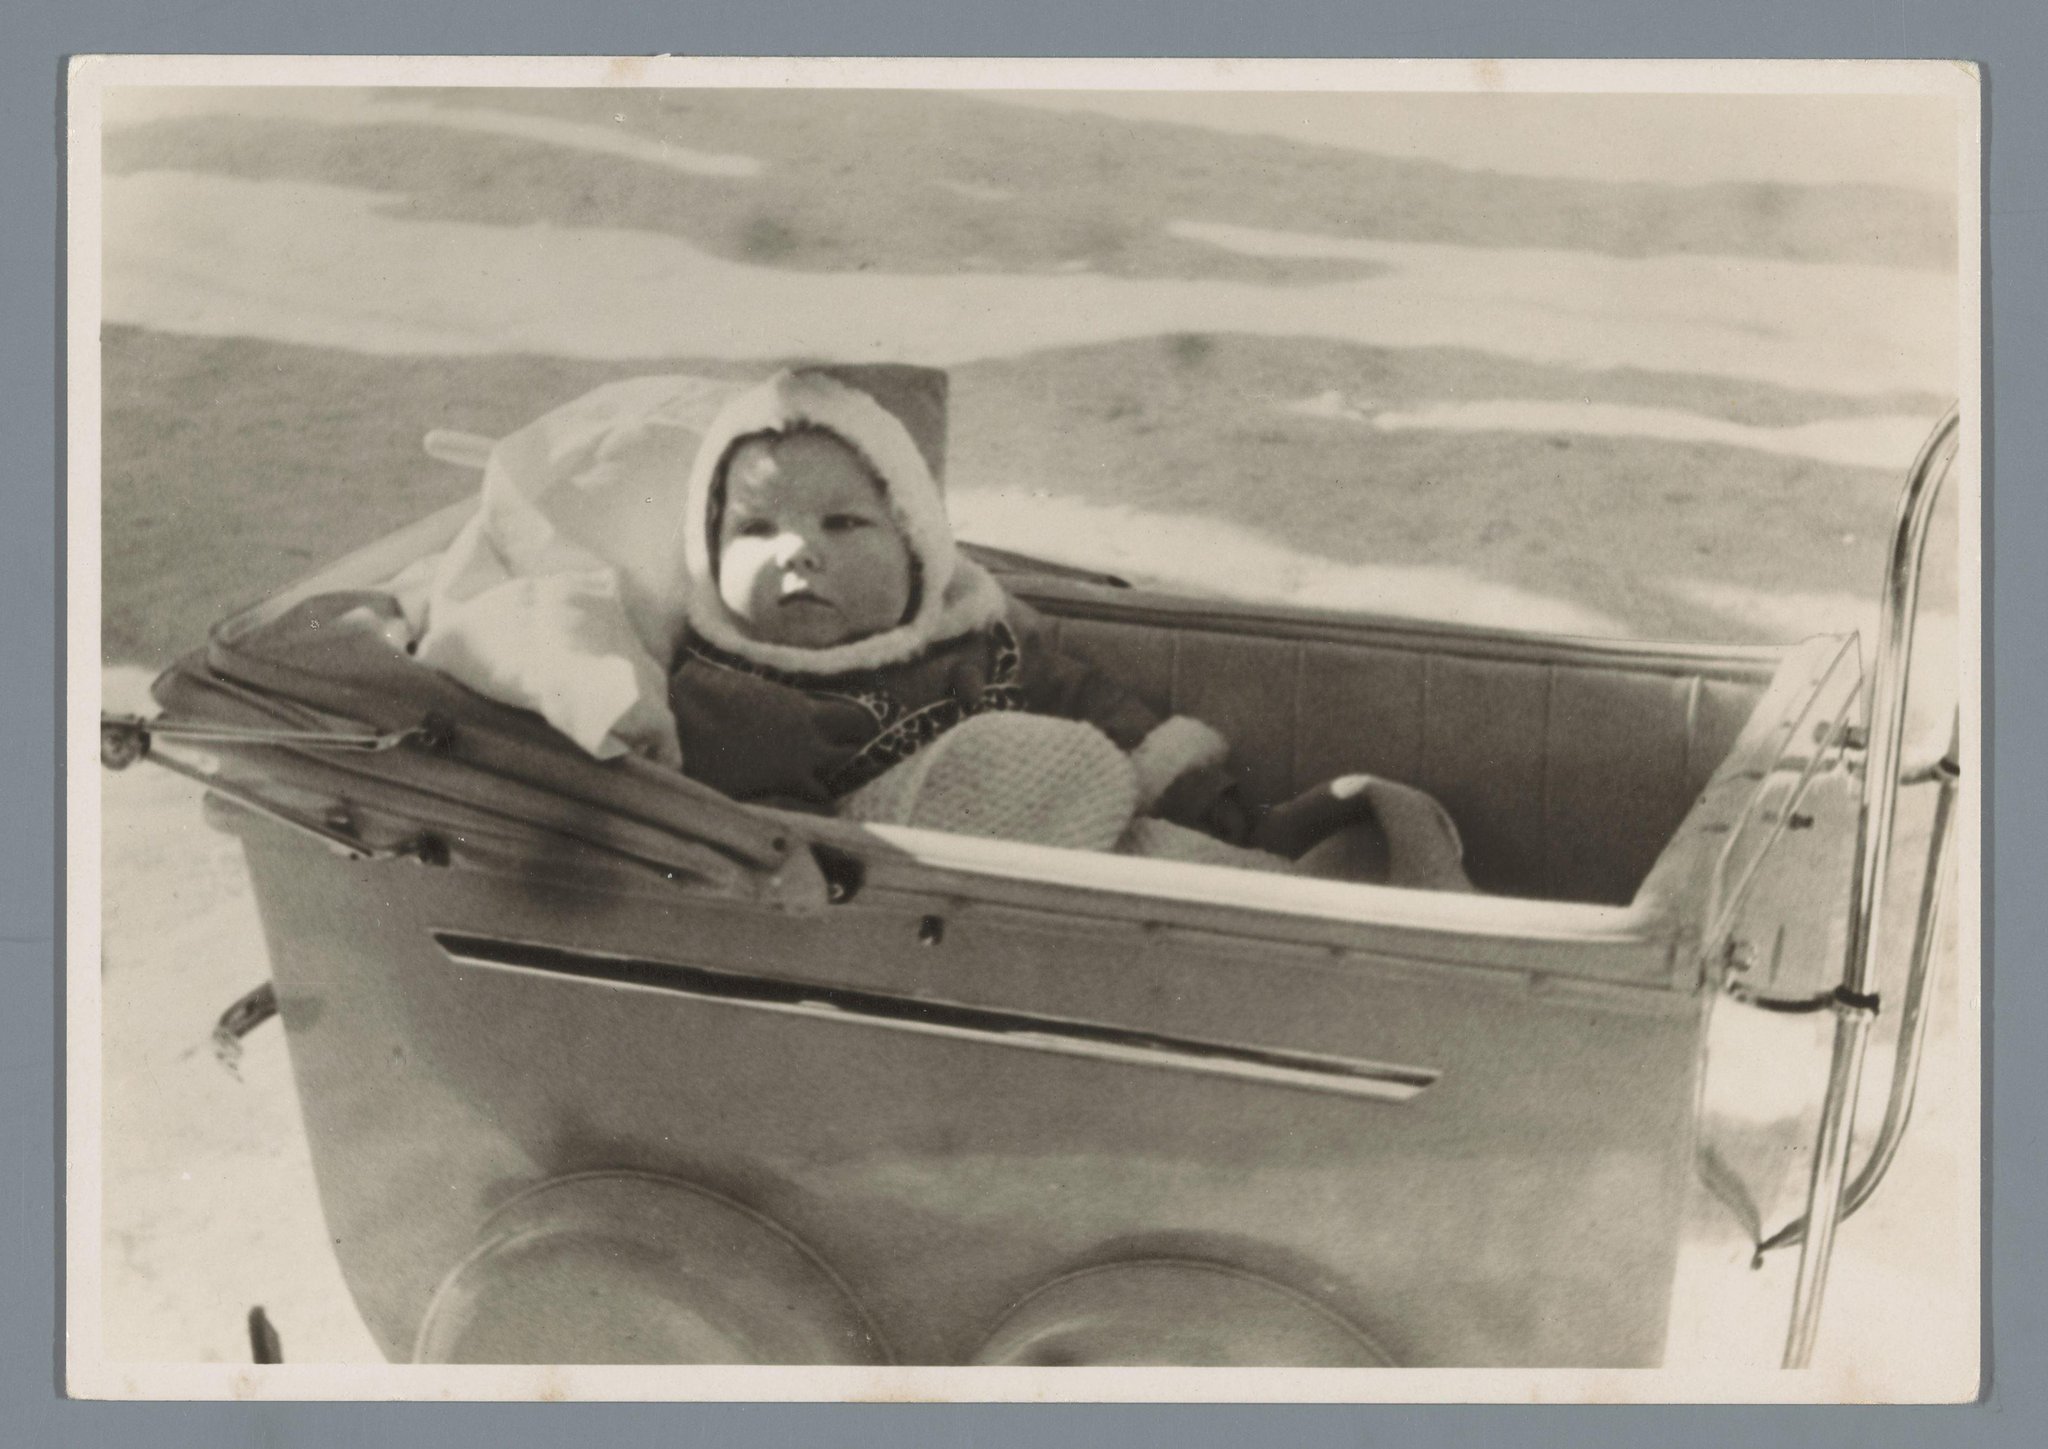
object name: ansichtkaart, prentbriefkaart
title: Prinses Beatrix in een kinderwagen tijdens de wintersportvakantie in Grindelwald, Zwitserland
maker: Anonymous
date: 1939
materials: photographic support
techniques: gelatin silver print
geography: amsterdam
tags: beatrix (koningin der nederlanden), baby-carriage, pram, perambulator, female infant, princess